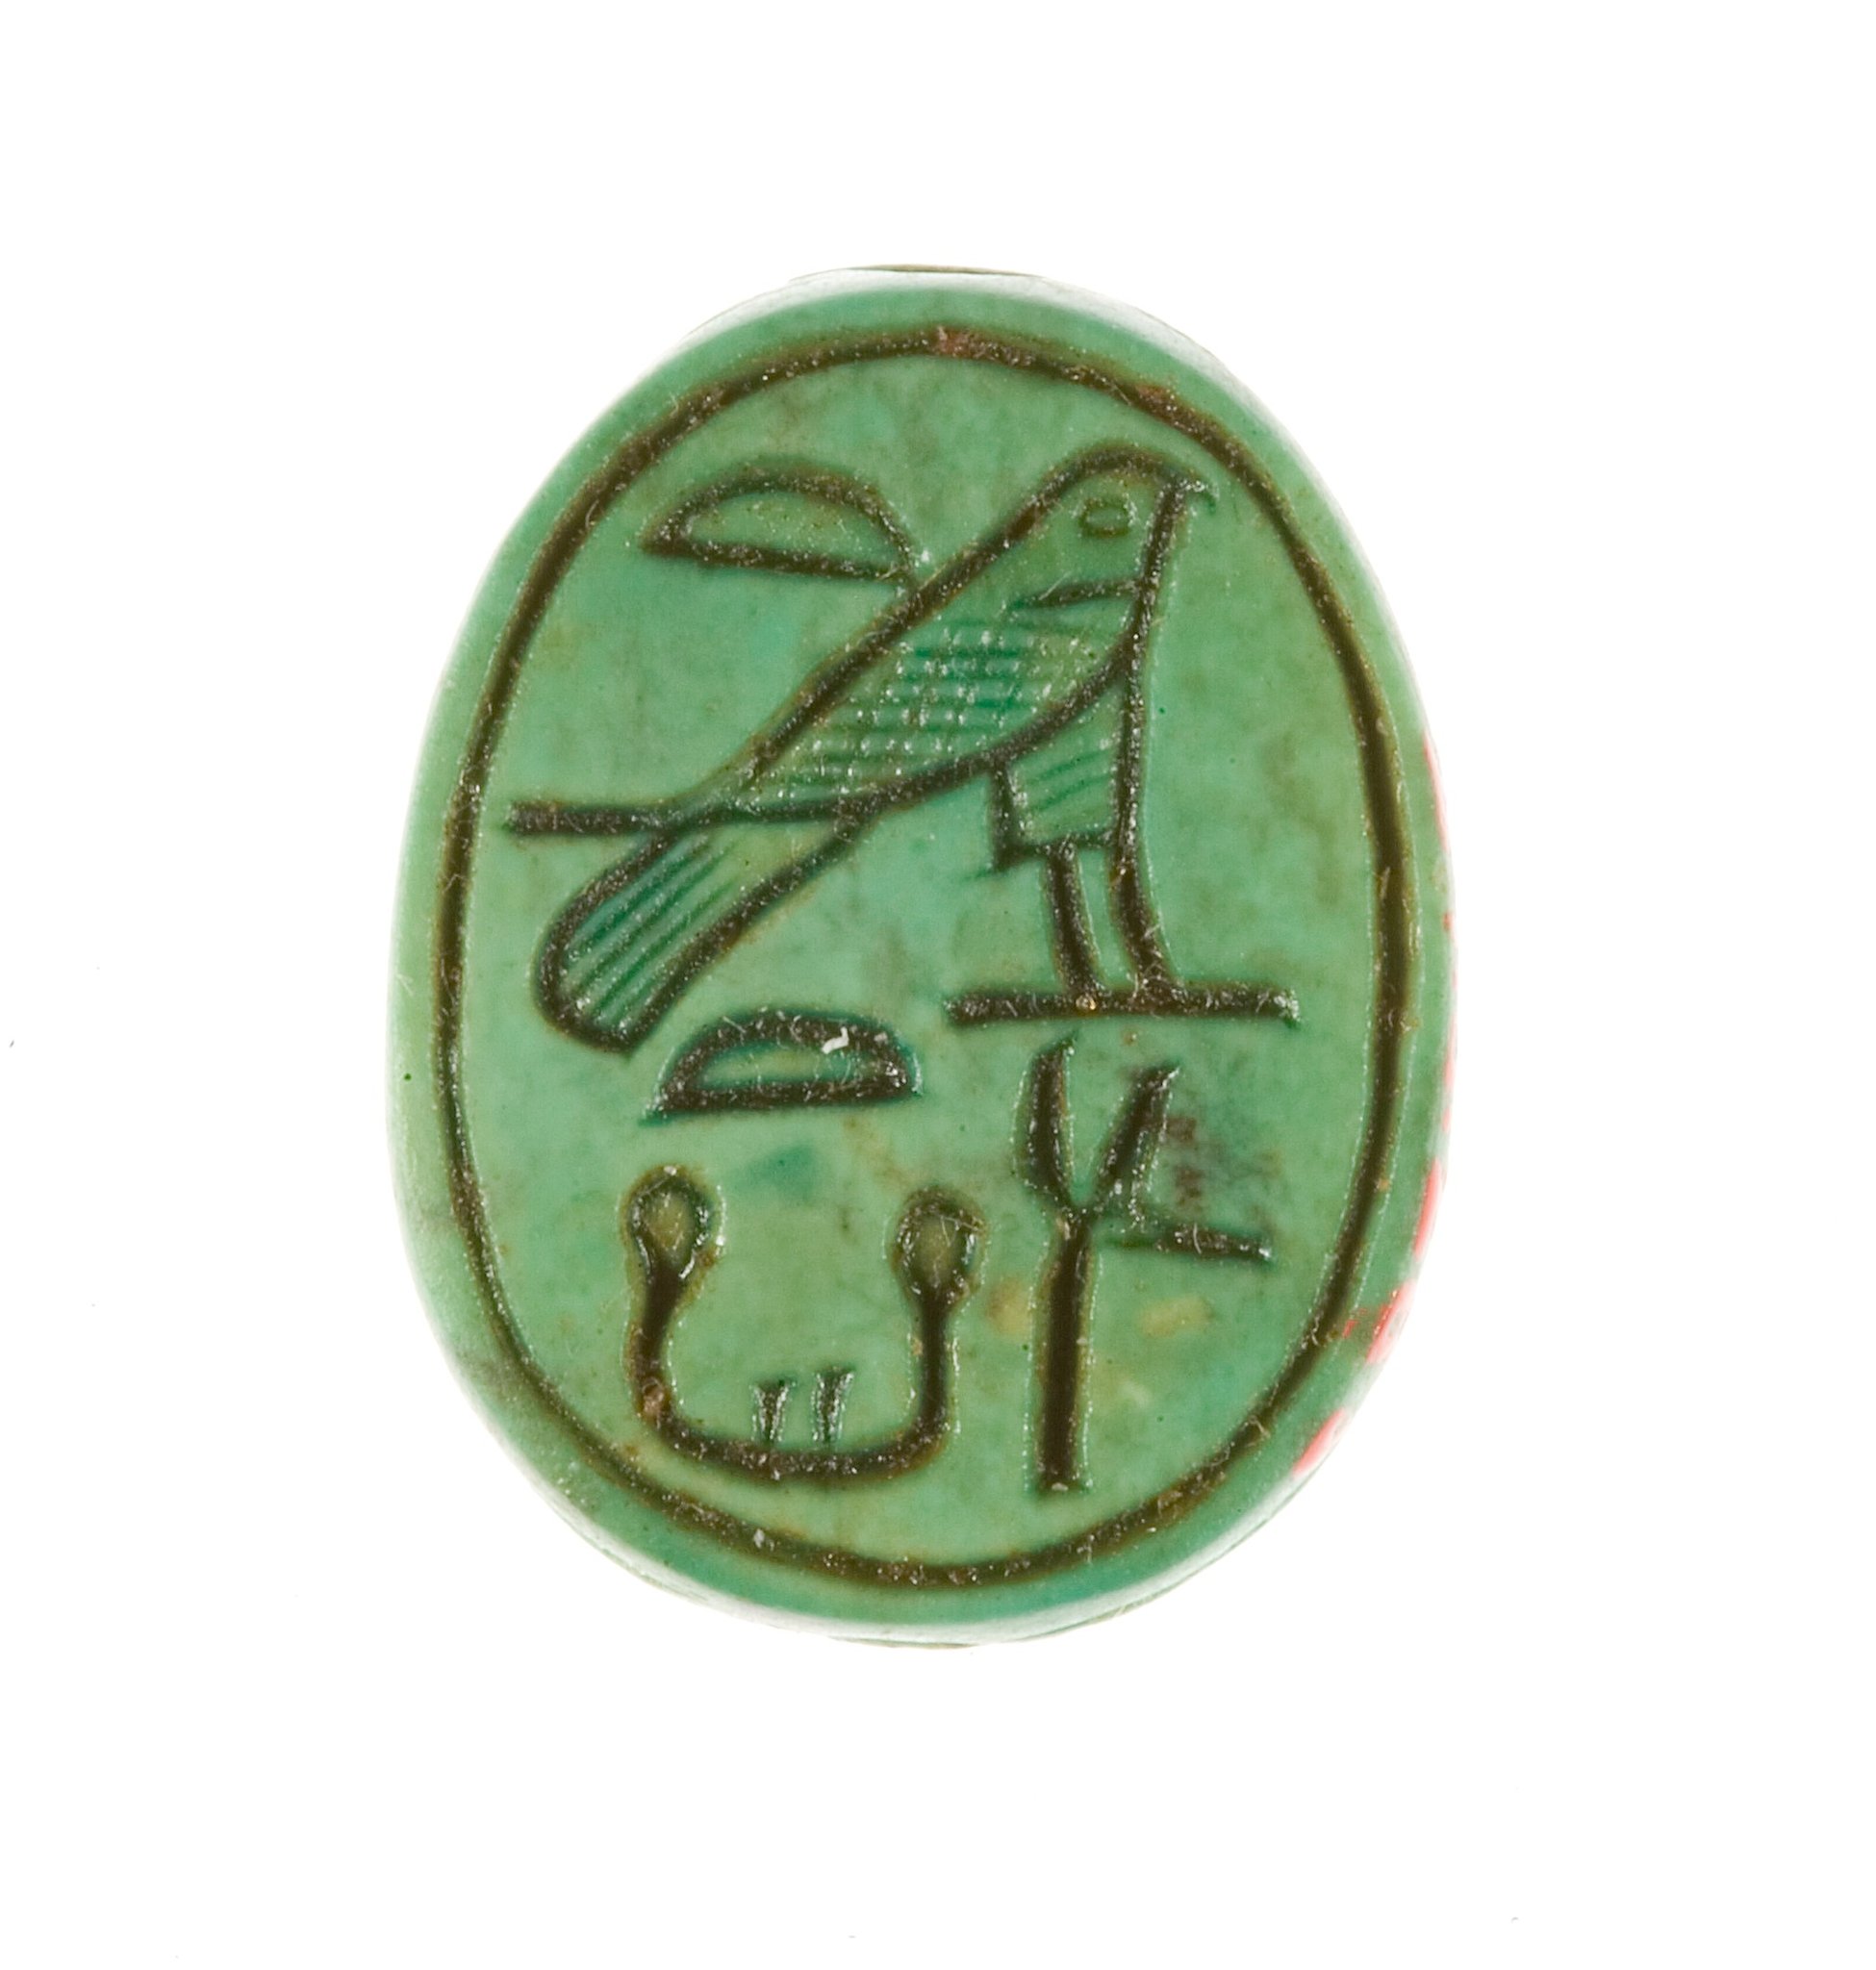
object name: scarab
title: Scarab Inscribed for the "Female Horus, Wosretkau"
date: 1479-1458 BCE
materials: stone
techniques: glazing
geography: egypt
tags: birds,scarabs